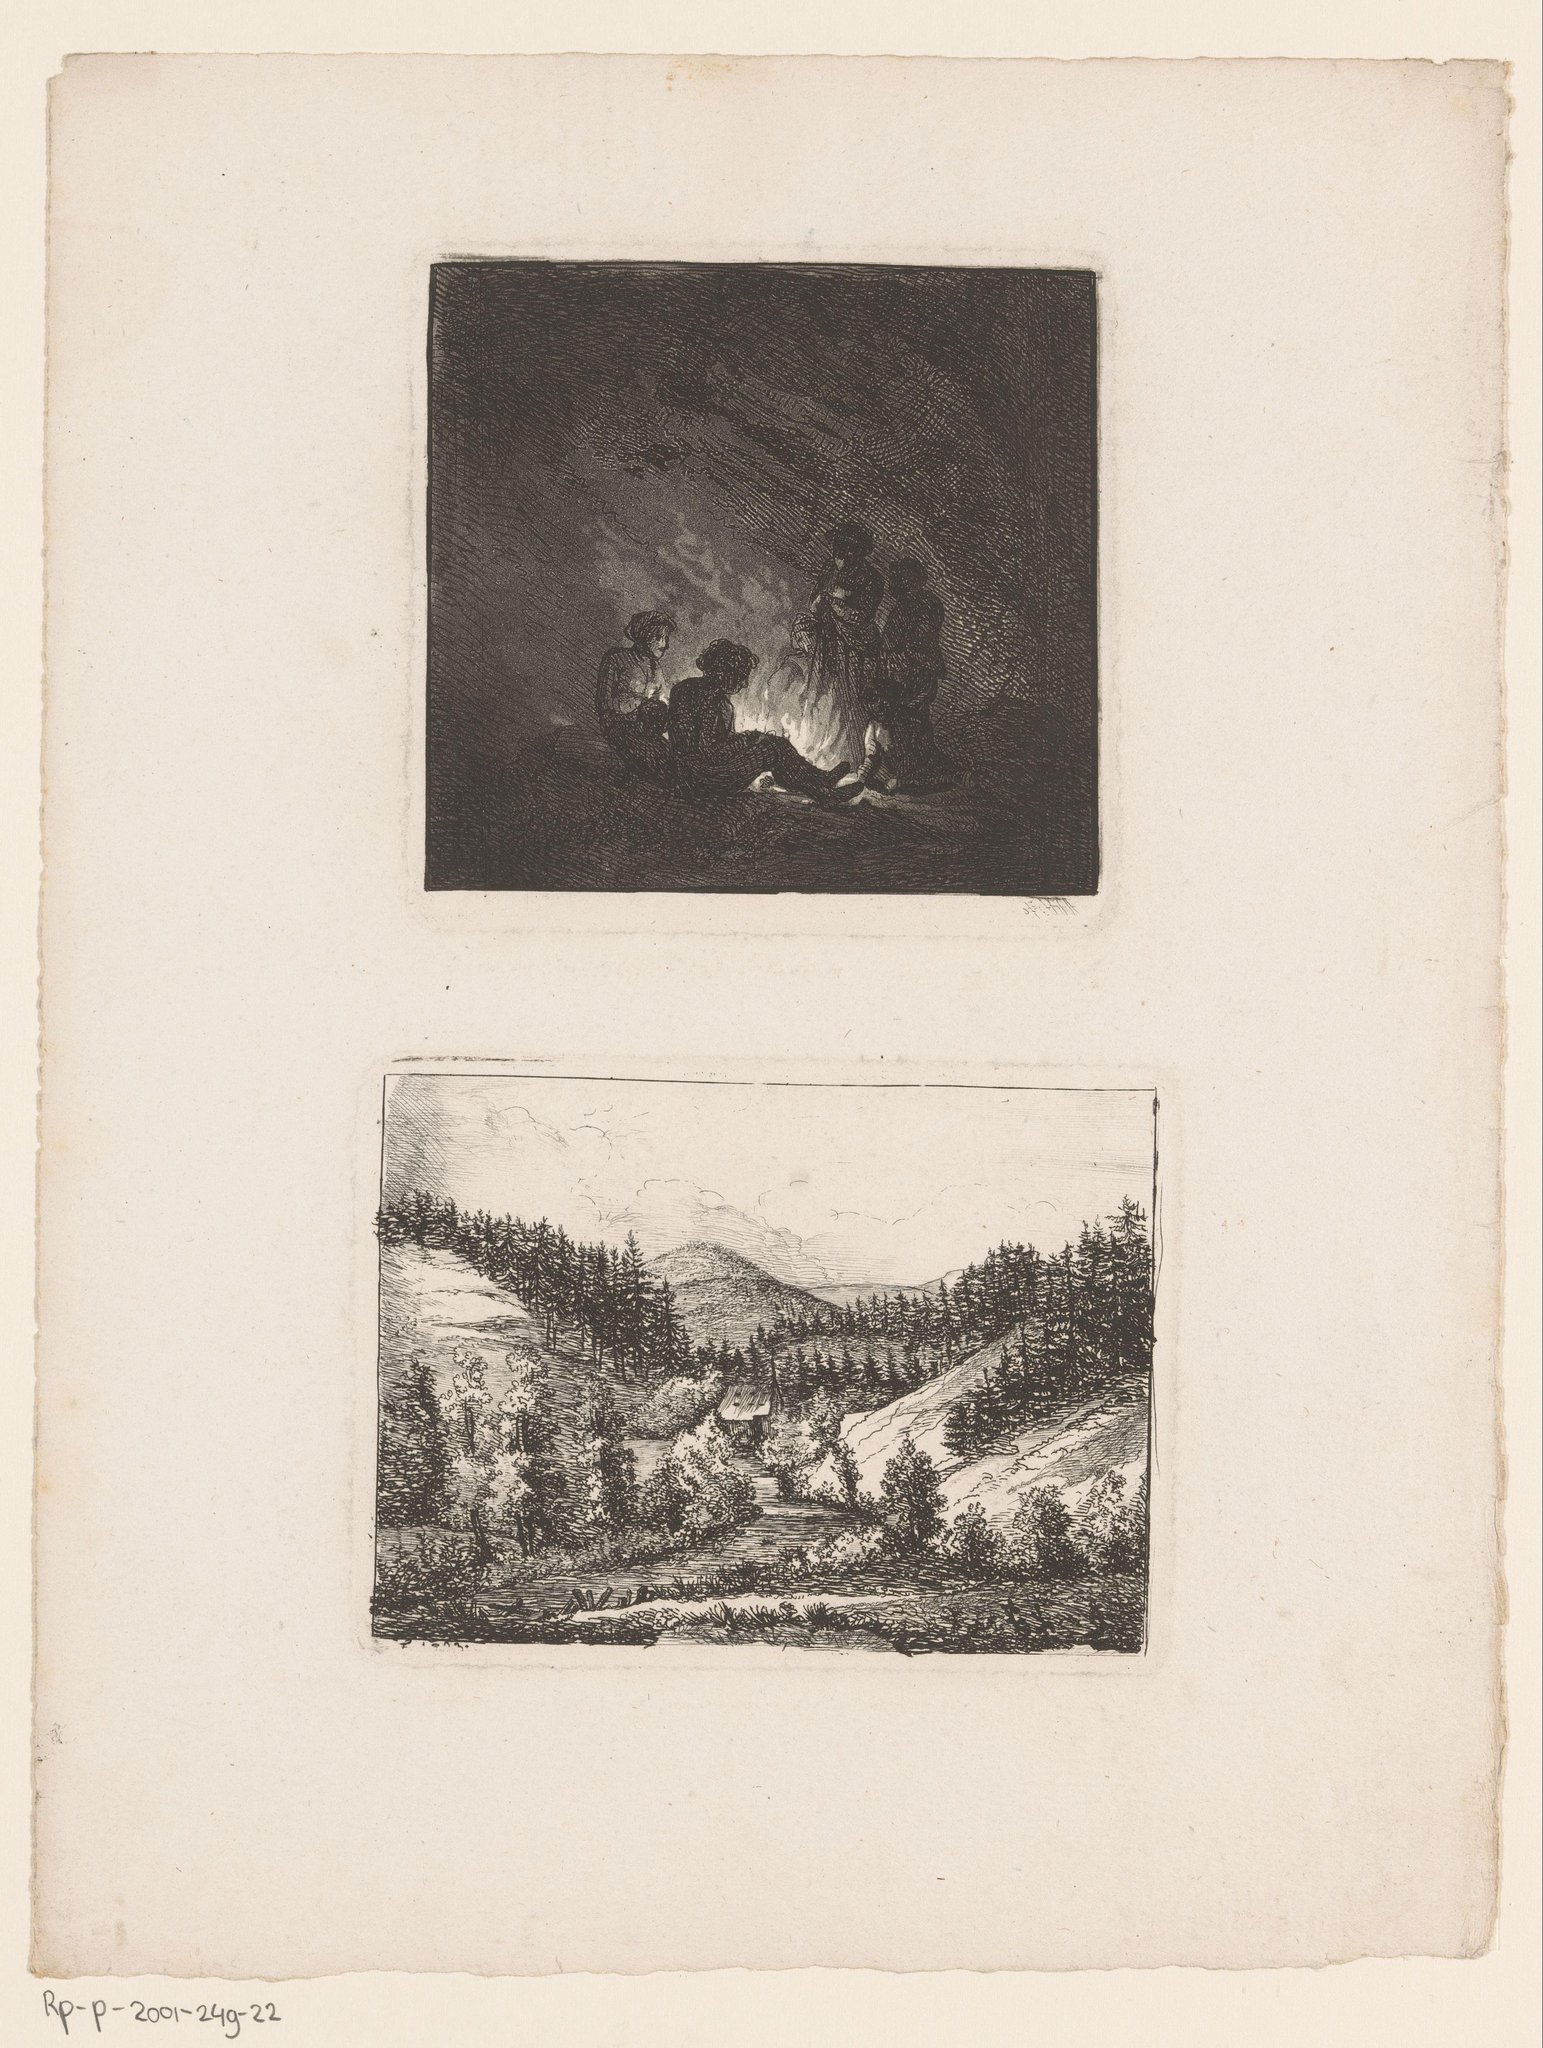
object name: print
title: Mijn eerste etsproeven in een reeks van 28 bladen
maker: marie anna fischer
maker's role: print maker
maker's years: 1782-1844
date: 1804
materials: paper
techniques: etching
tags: camp-fire; watch-fire, trees: pine, night, mountains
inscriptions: collector's mark: Lugt 2760, collector's mark: Lugt 2228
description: De originele prentserie bevat 40 prenten op 28 bladen. Het RMA heeft 33 prenten op 22 bladen in de collectie.